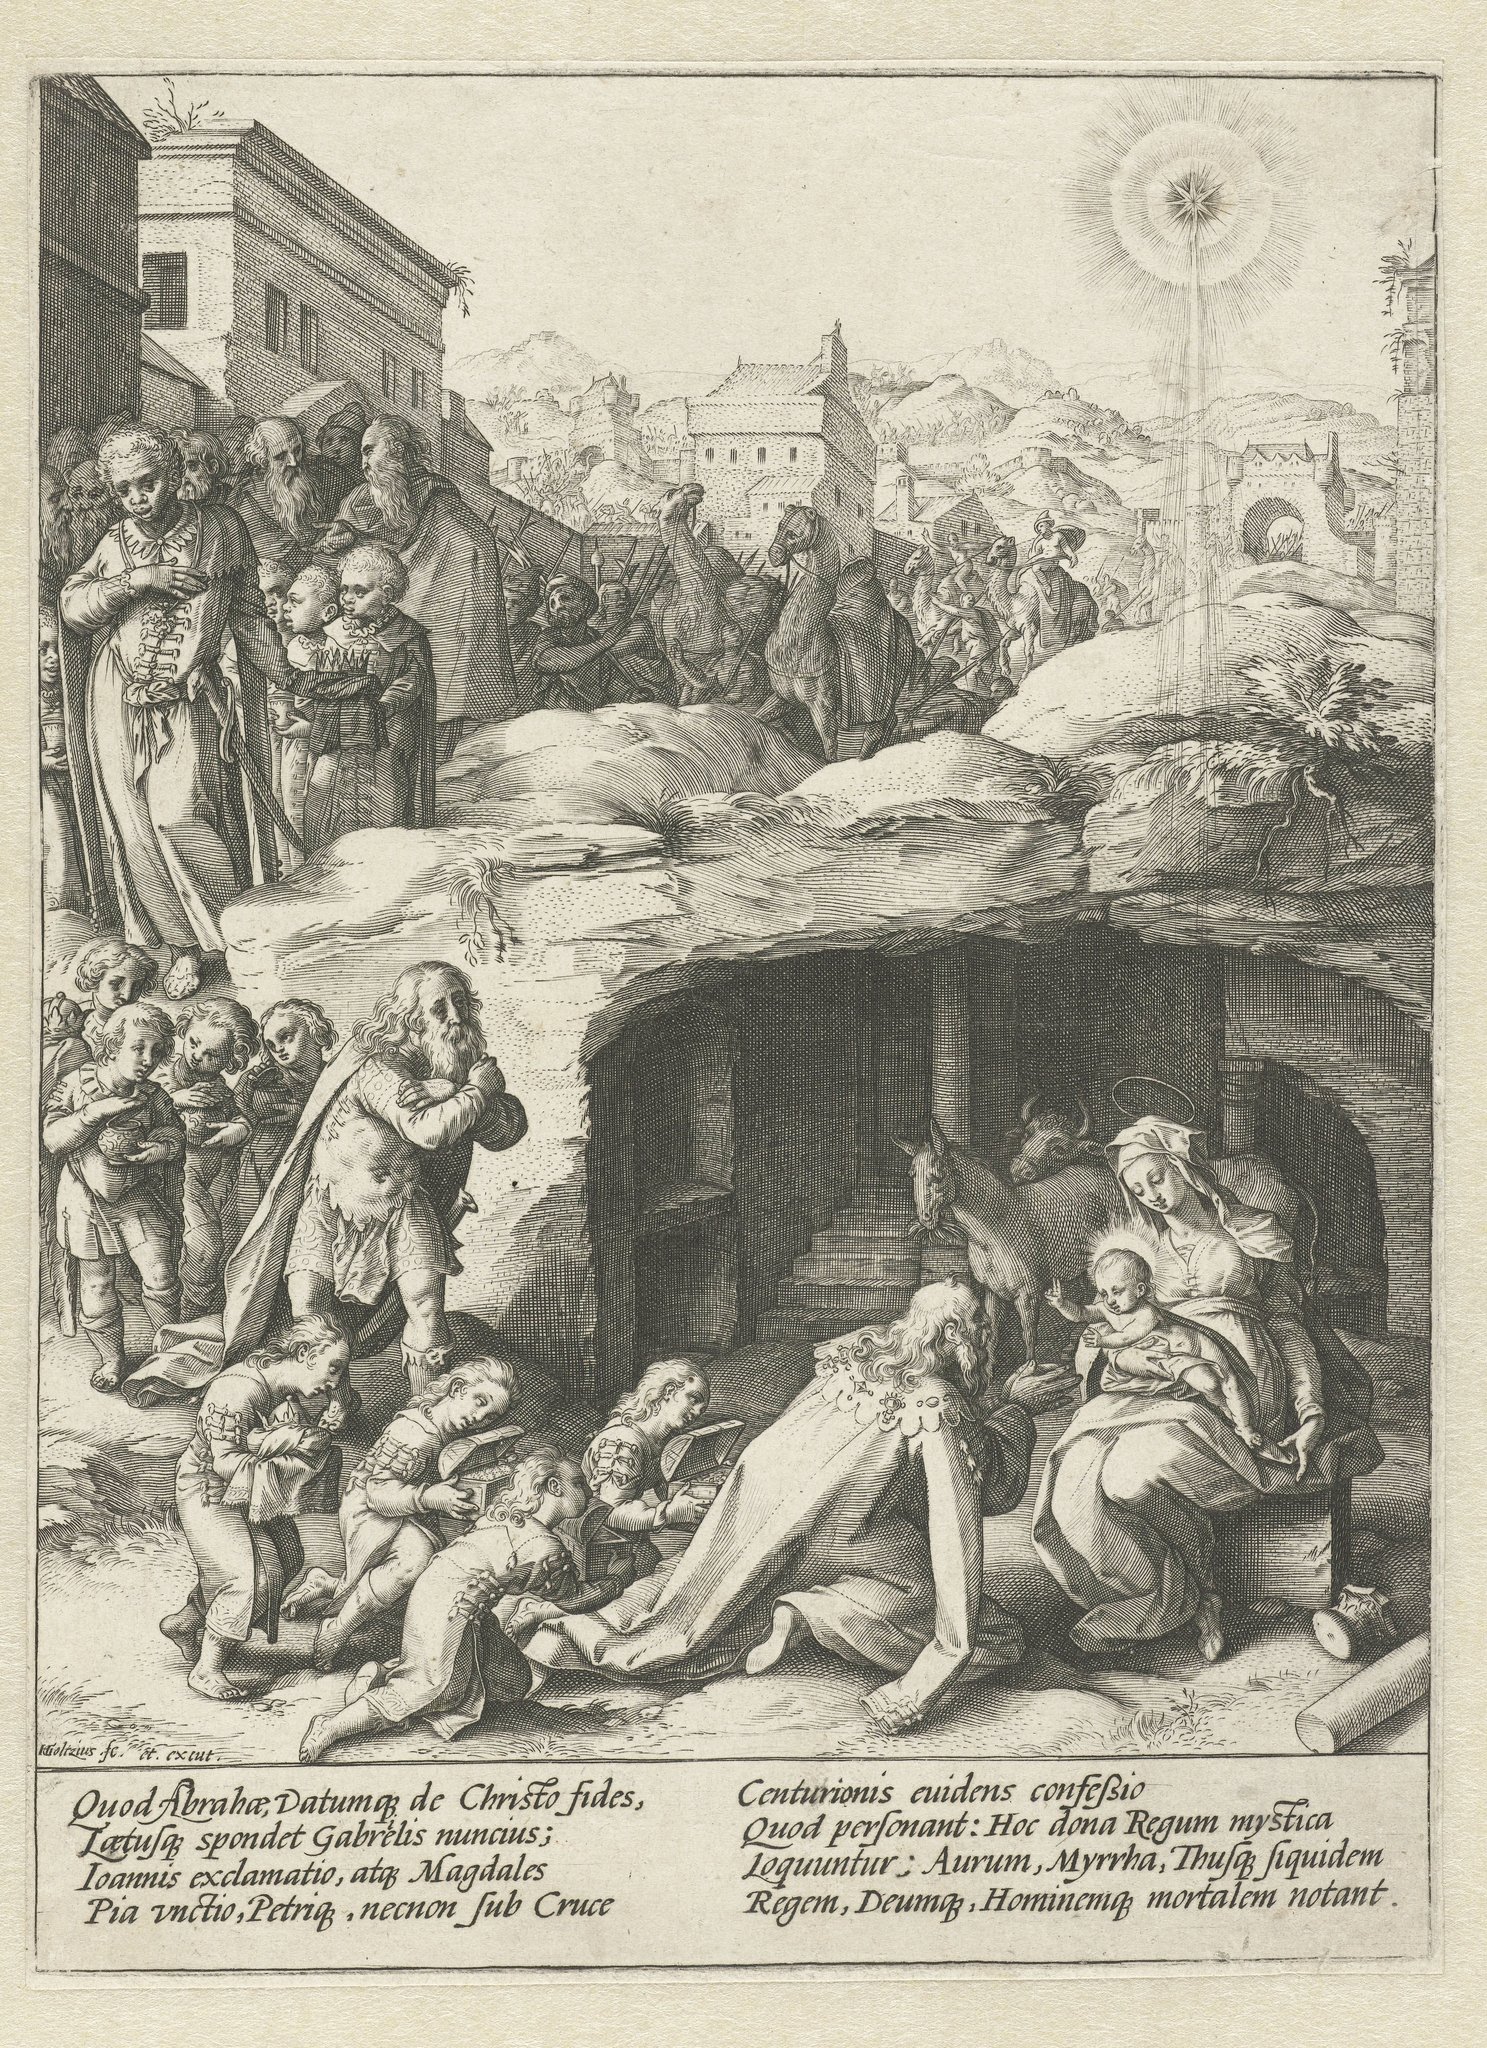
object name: print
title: Aanbidding door de koningen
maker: hendrick goltzius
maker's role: draughtsman, painter, print maker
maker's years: 1558-1617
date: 1584-1588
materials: paper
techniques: engraving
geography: haarlem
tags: adoration of the kings: the wise men present their gifts to the christ-child (gold, frankincense and myrrh)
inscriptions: signature: ‘HGoltzius fe et. excut.’, collector's mark: Lugt 240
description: Voor een grot zit Maria met het Christuskind op schoot. Door een stadspoort achter trekt de stoet bestaande uit de koningen en hun gevolg langs. In marge onder de prent acht regels Latijn.